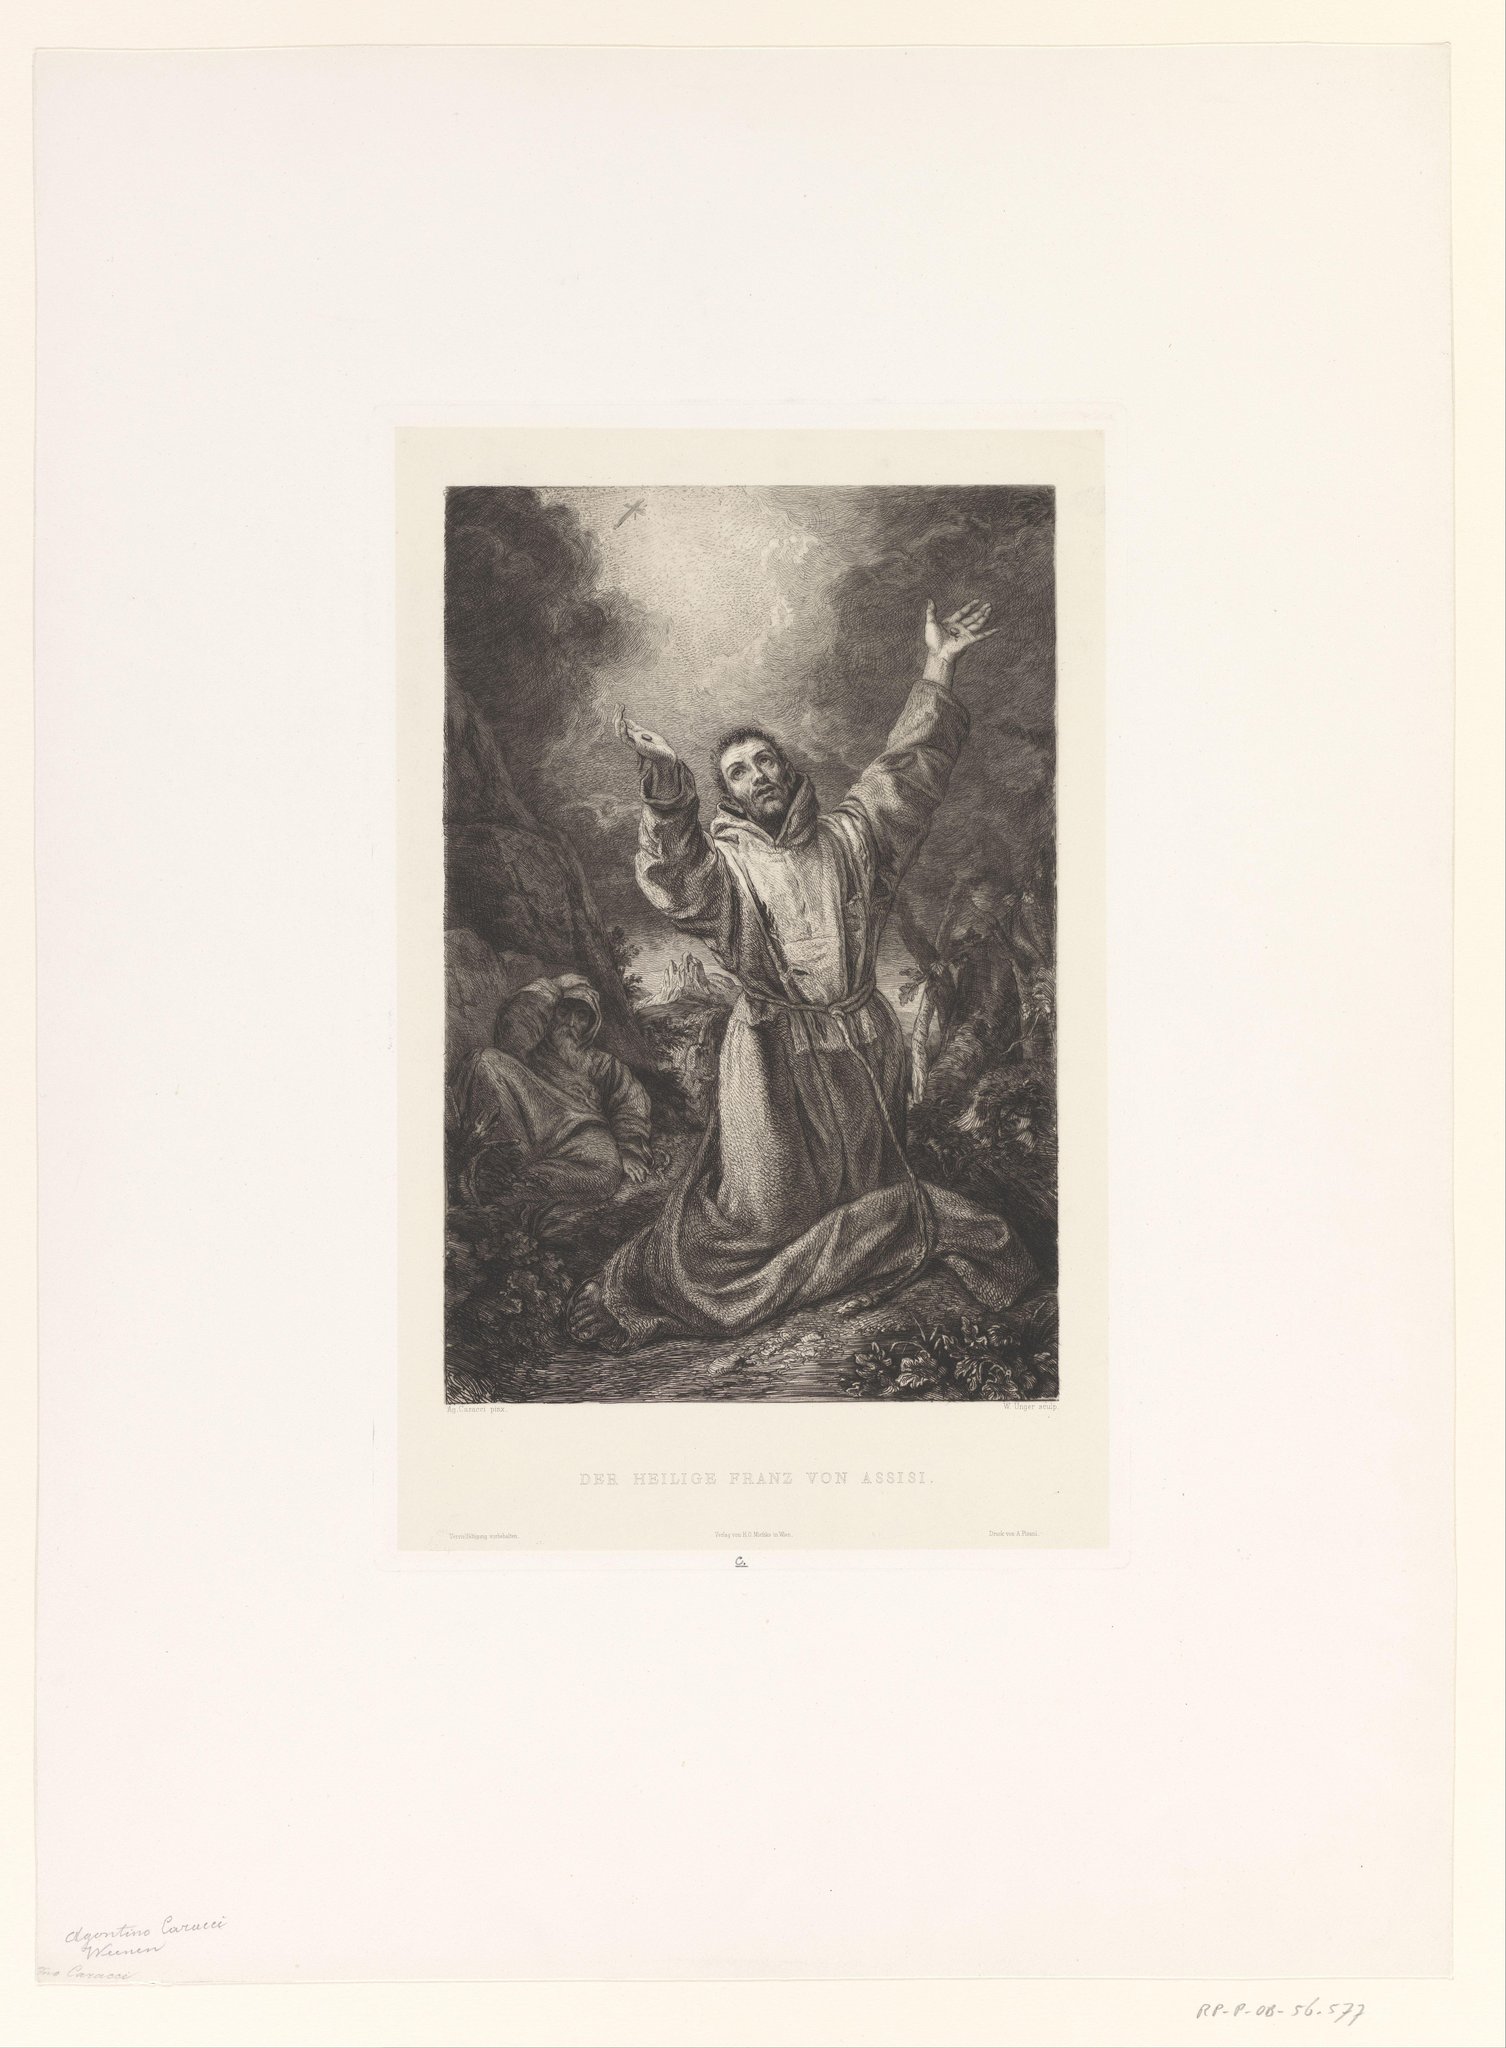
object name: print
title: Der heilige Franz von Assisi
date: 1861-1889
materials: paper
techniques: etching, intaglio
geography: vienna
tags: stigmatization of st. francis of assisi: in retreat on mount alverna, he beholds a vision of christ on the cross enveloped by wings (like a seraph with six wings); rays passing down to the body of the kneeling saint form the marks of the five wounds of christ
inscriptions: collector's mark: Lugt 2228